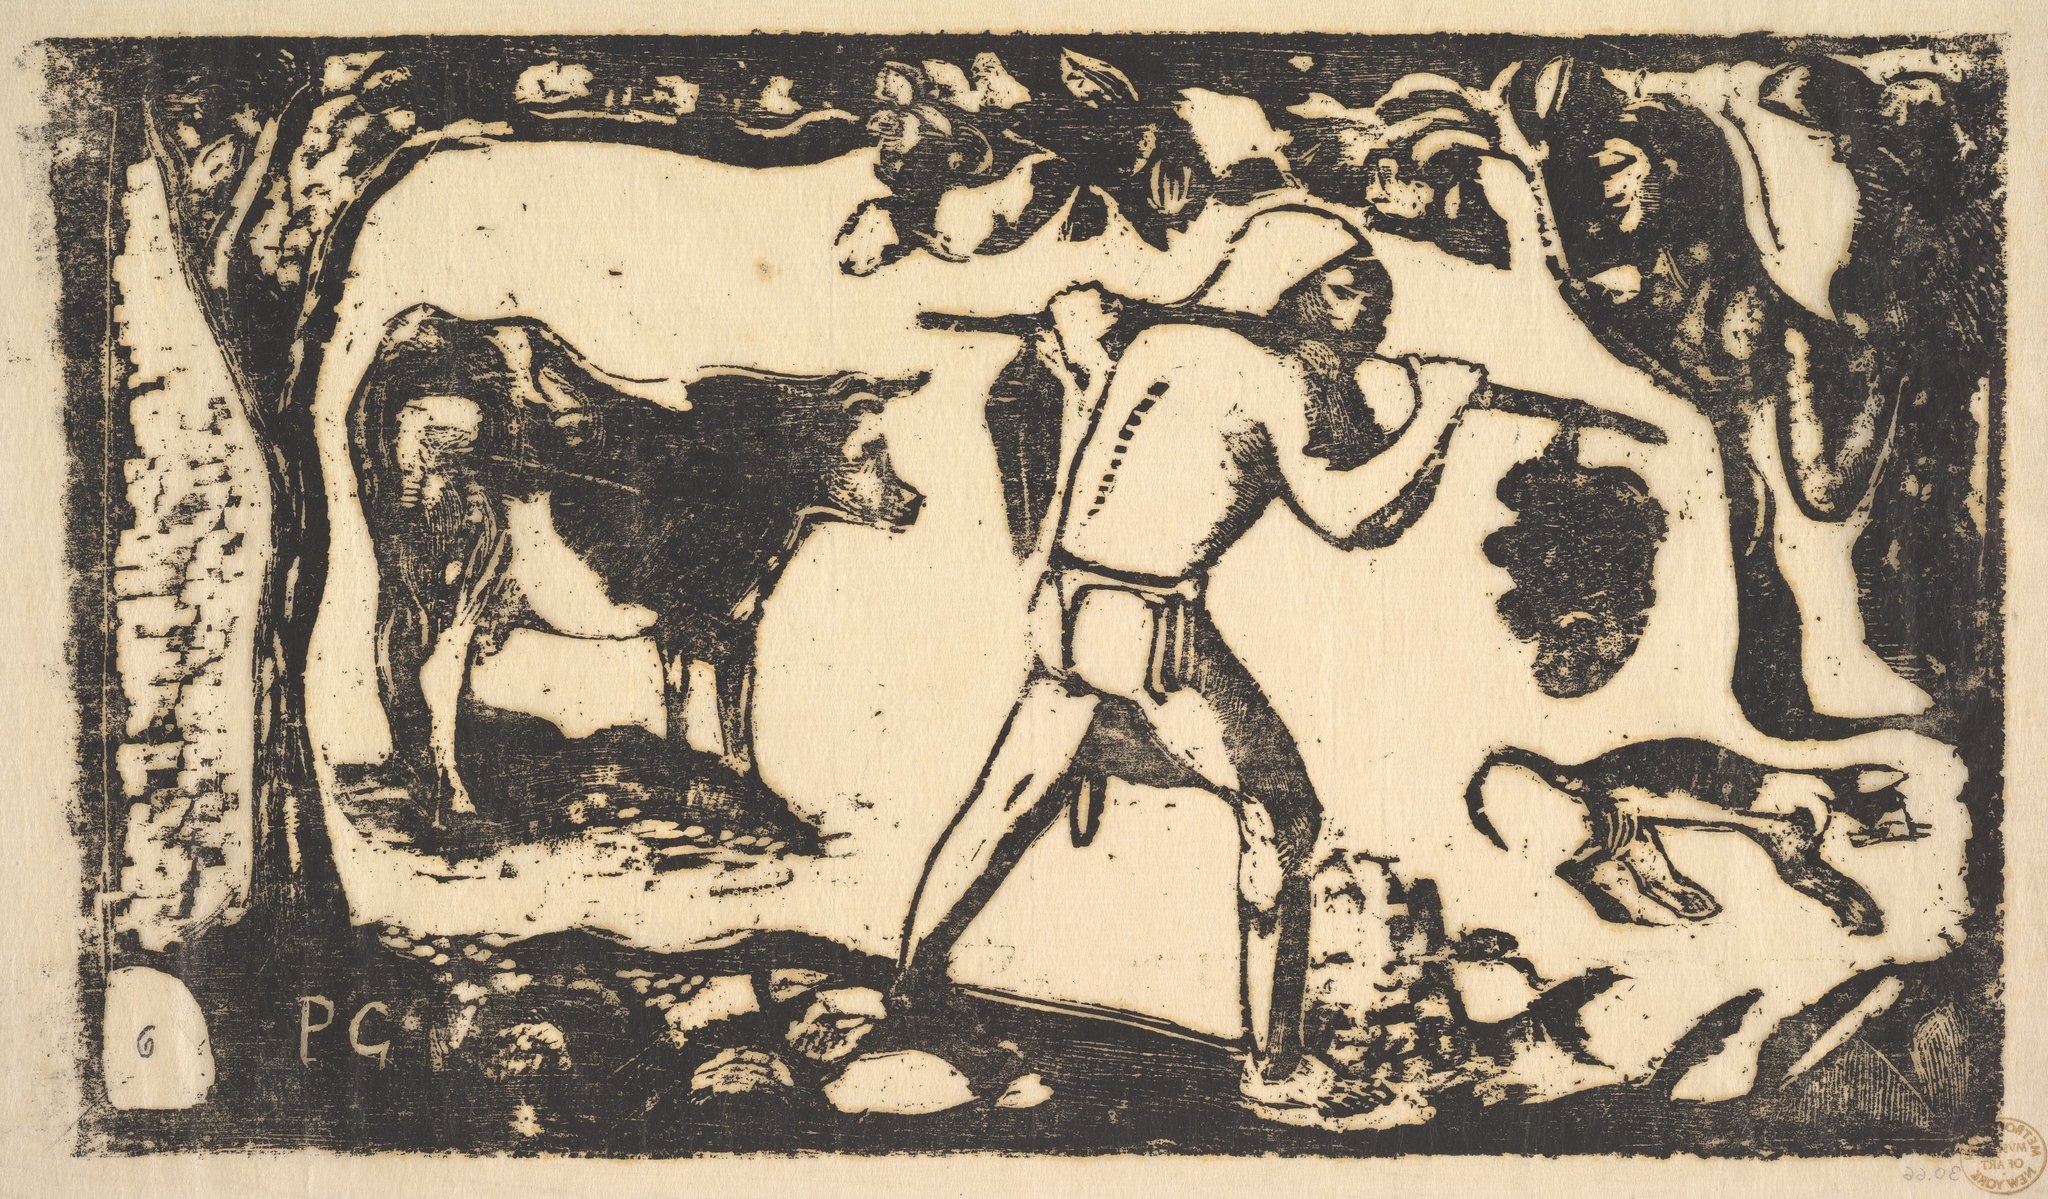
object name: print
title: Tahitian Carrying Bananas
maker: paul gauguin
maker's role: artist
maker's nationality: french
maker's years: 1848-1903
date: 1898-1899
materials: paper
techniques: woodcut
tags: fruit,men,cows,dogs